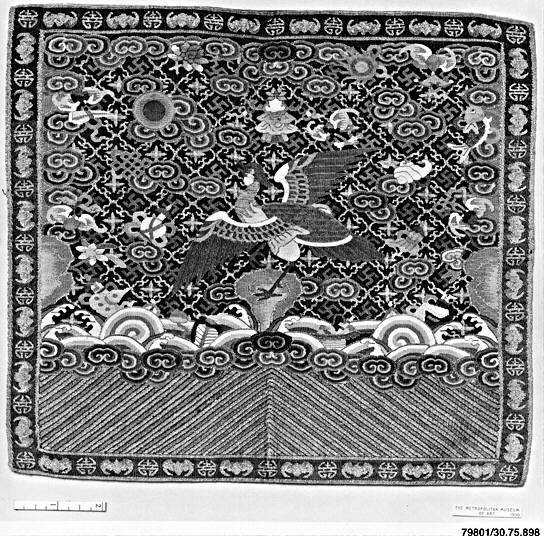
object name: rank badge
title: Rank Badge with Mandarin Duck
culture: chinese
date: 1767-1833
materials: metal thread, silk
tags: bats,ducks